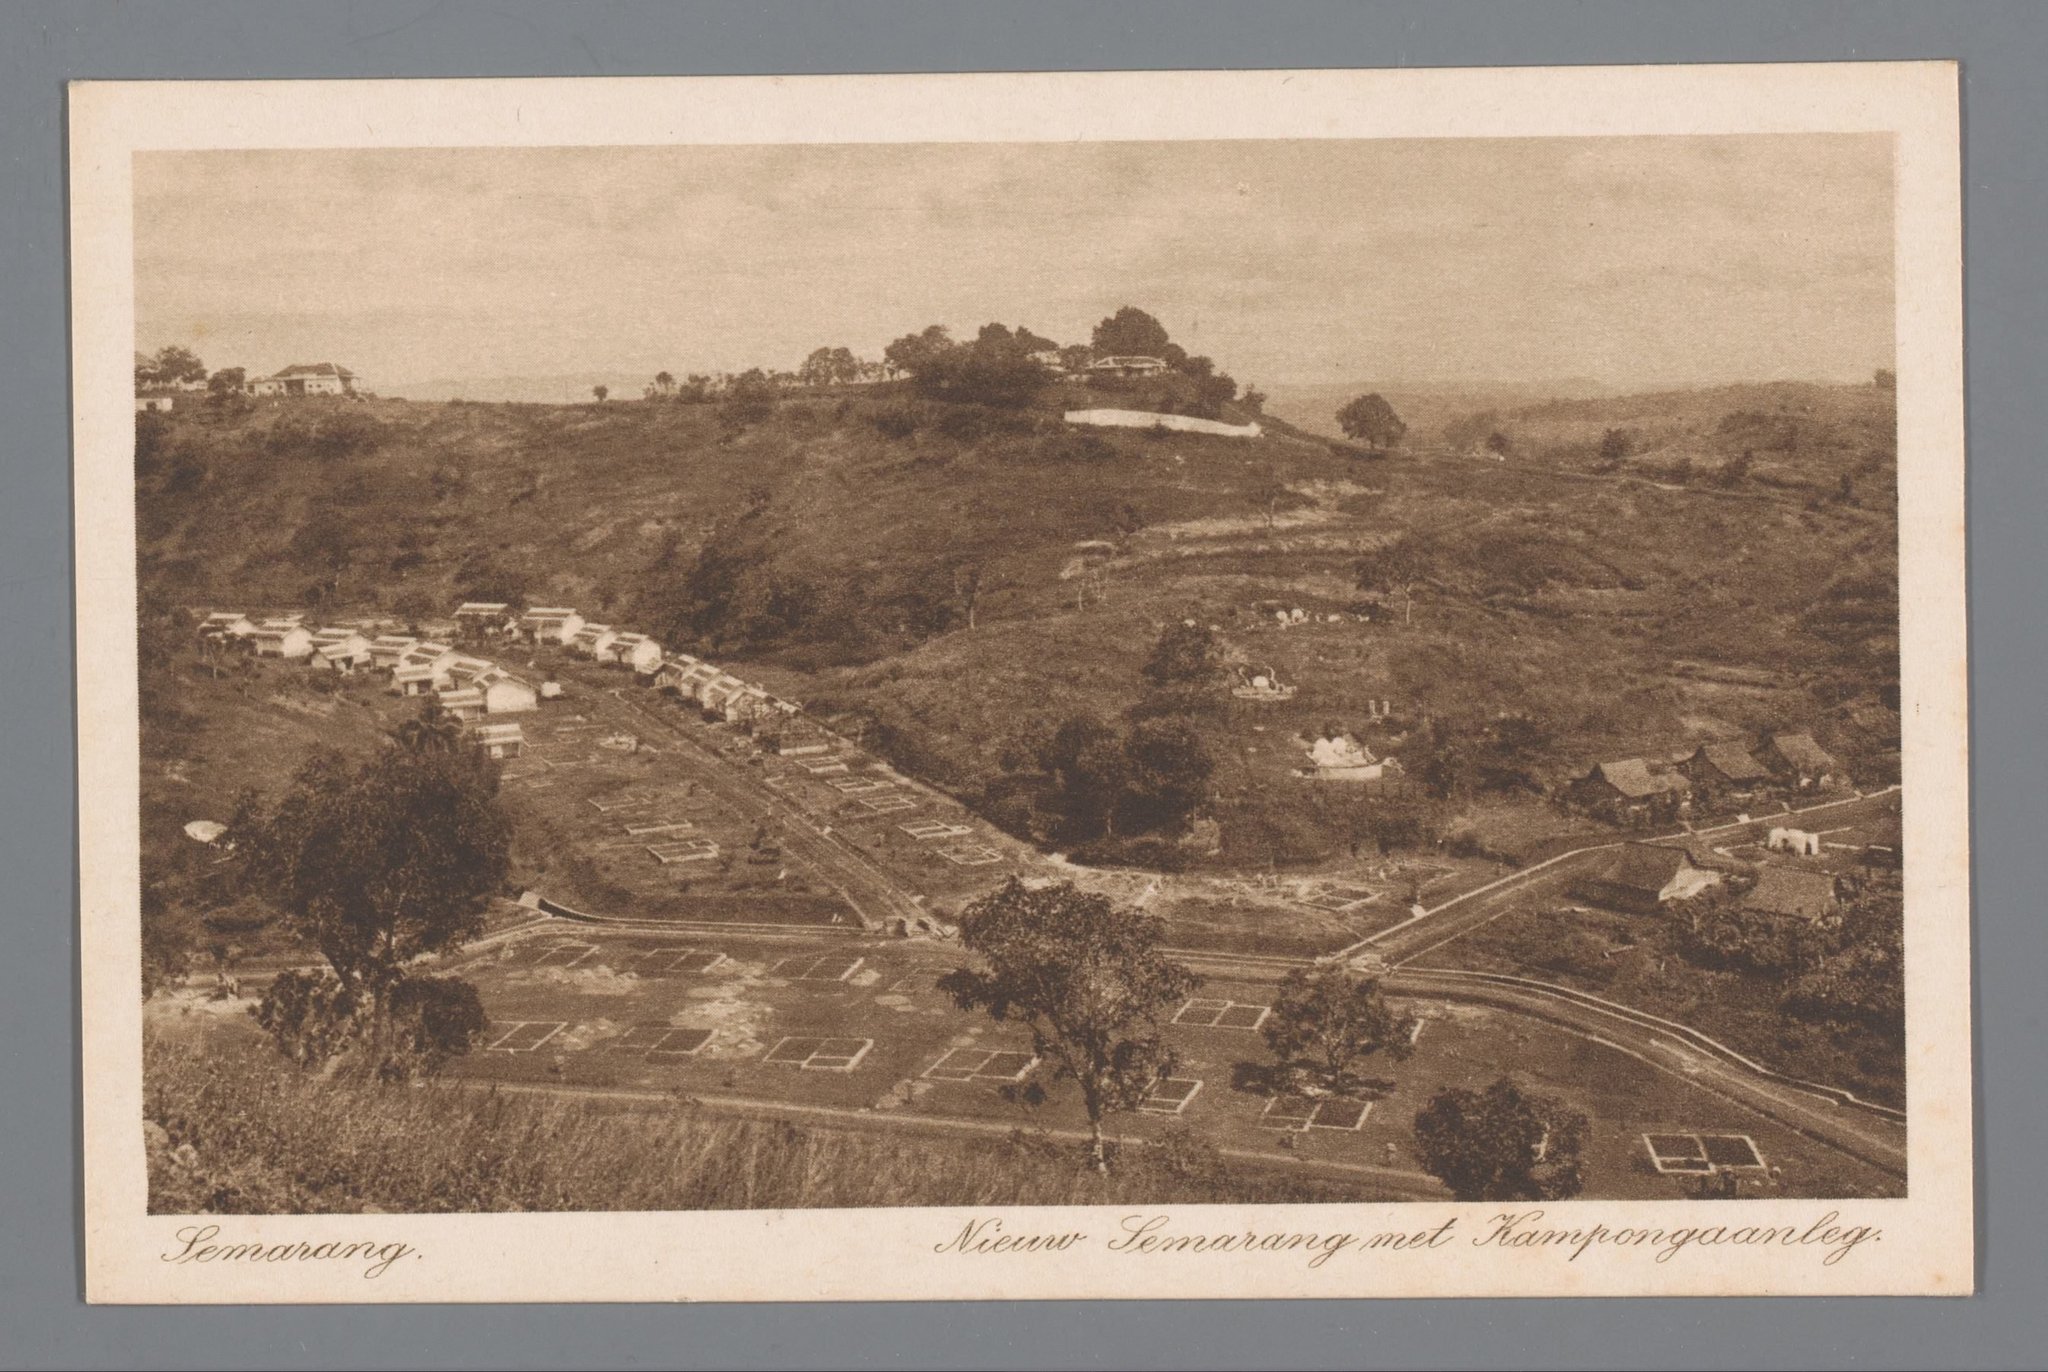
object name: photograph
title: Semarang. Nieuwe Semarang met Kampongaanleg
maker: otto hisgen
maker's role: fotograaf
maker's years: 1874-1944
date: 1900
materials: paper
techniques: photography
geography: semarang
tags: dutch east indies, the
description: Eén van zes briefkaarten, foto's in bruin, stadsgezichten van Nieuw-Semarang; achterzijde onbeschreven. Semarang ligt op midden-Java. Opmerking: zie NG-1011-A t/m F.